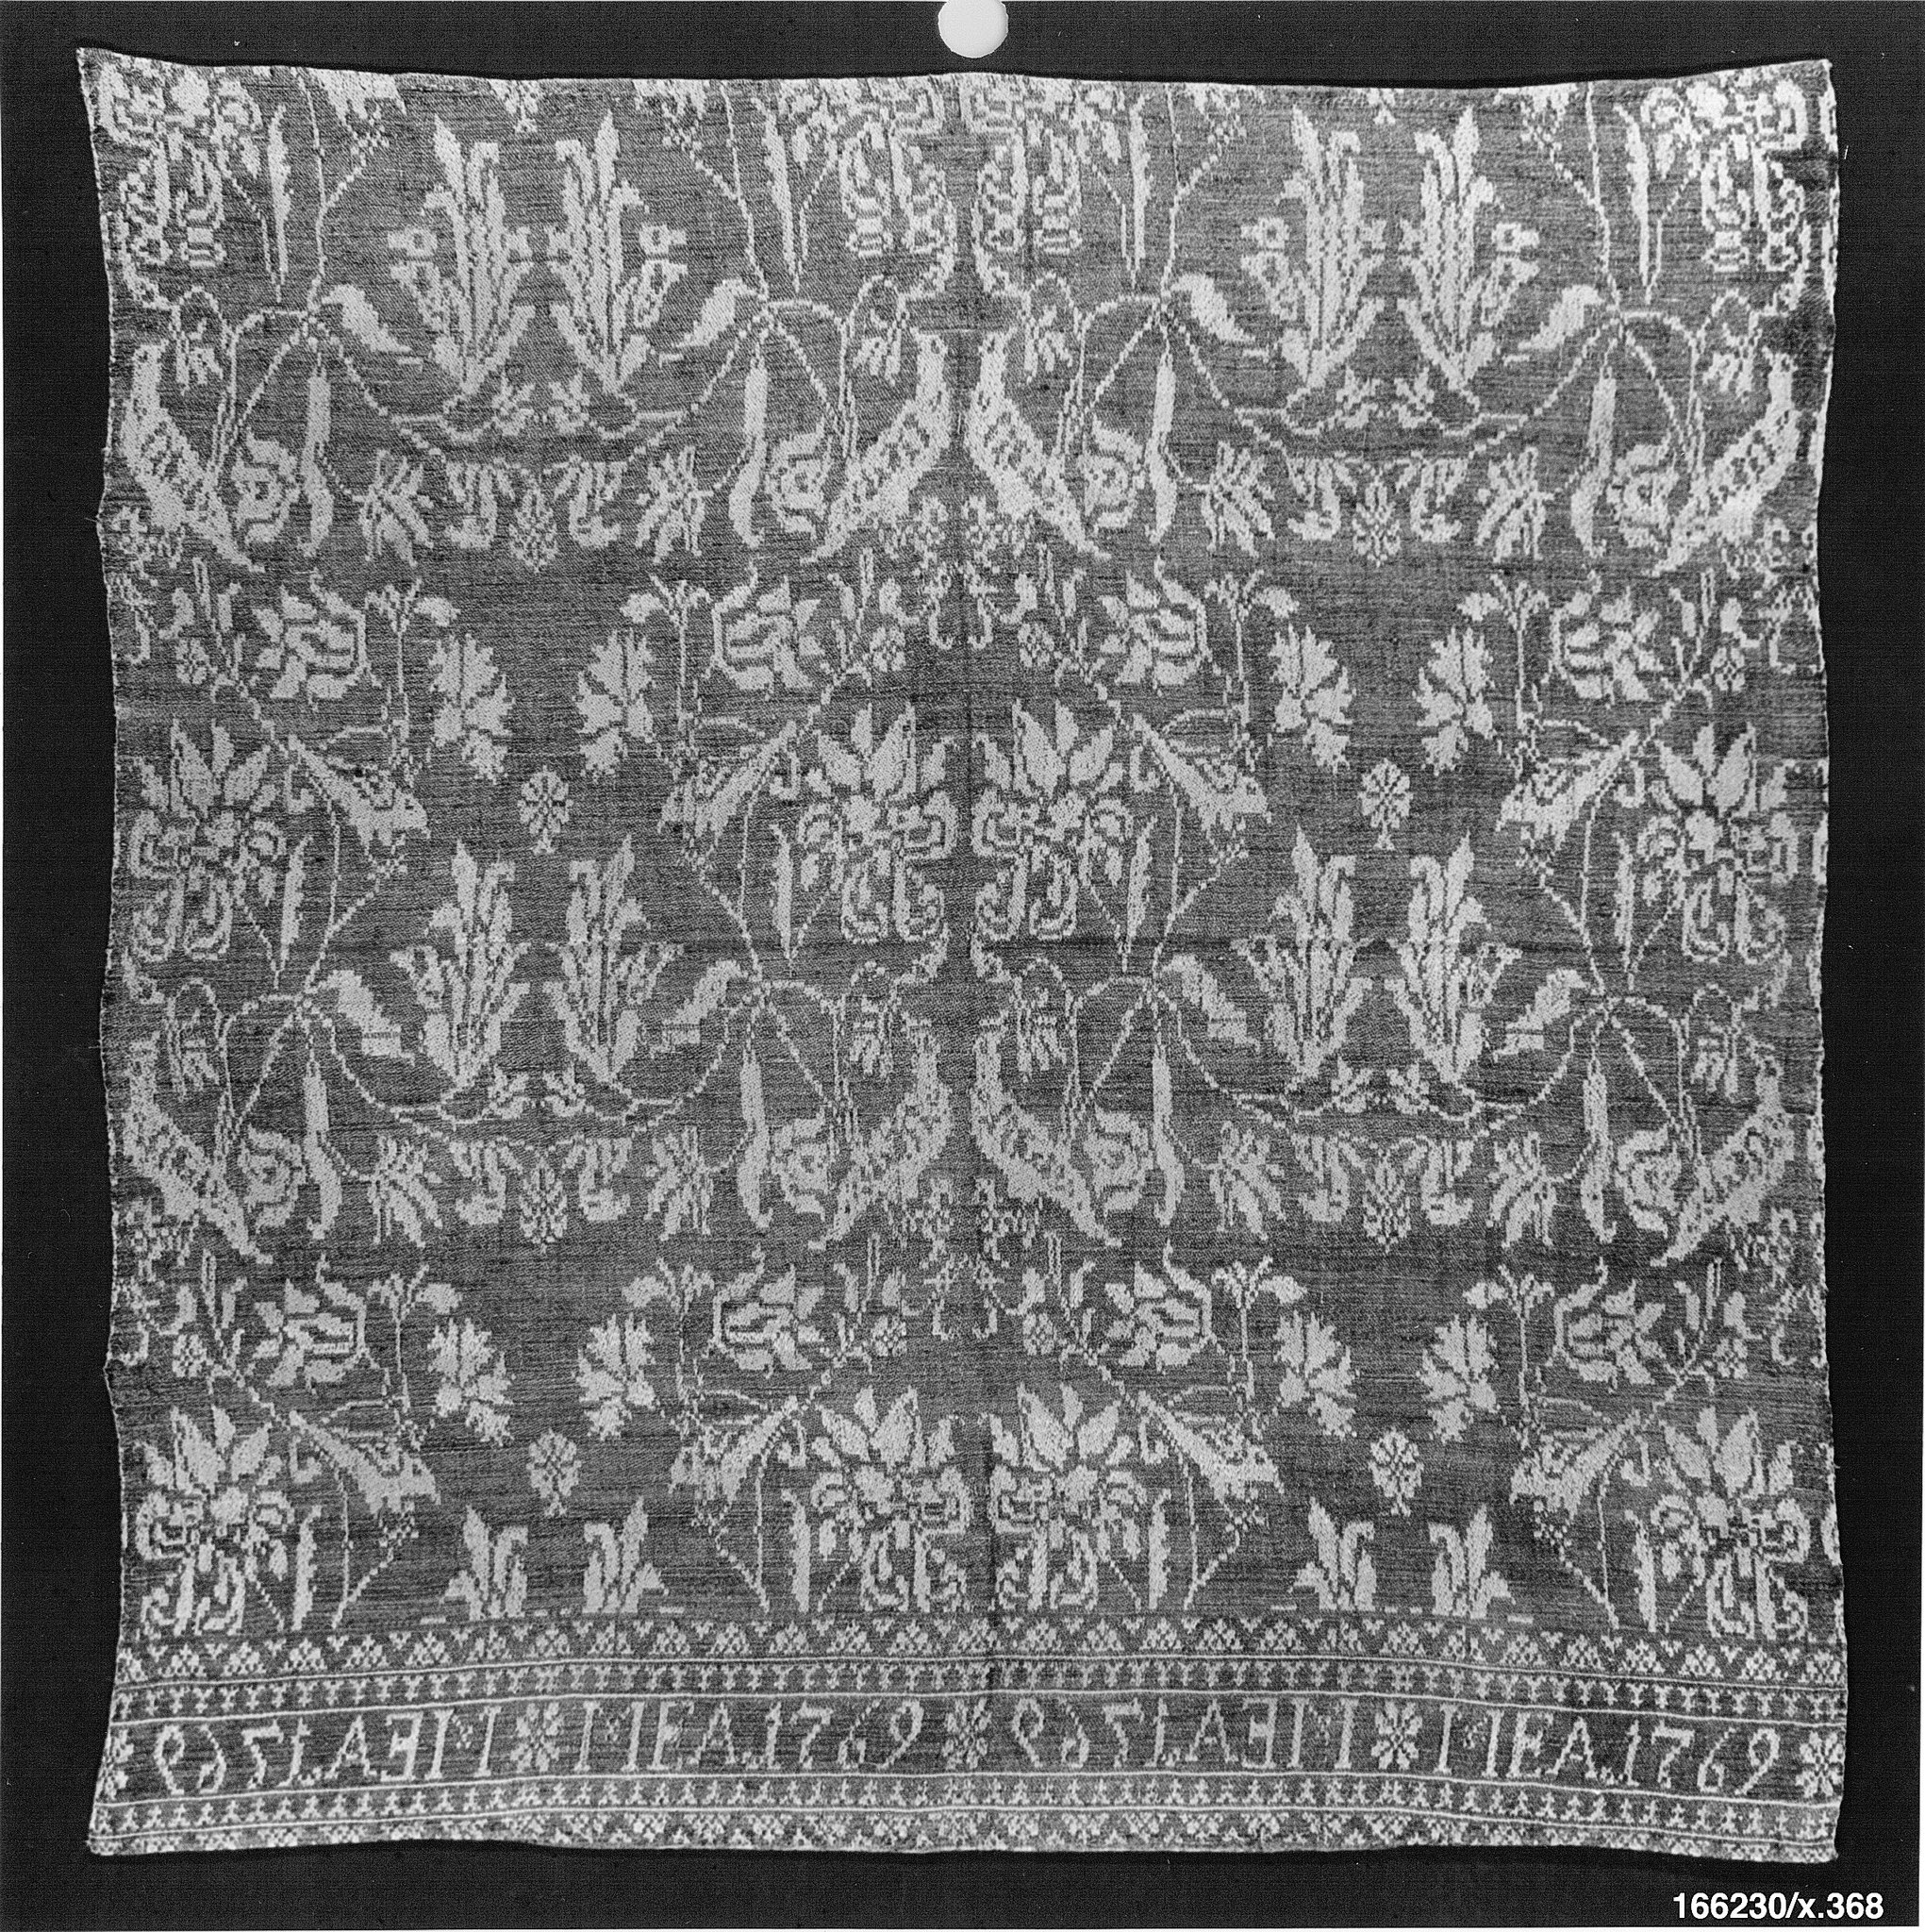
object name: piece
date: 1769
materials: linen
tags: birds,flowers,leaves